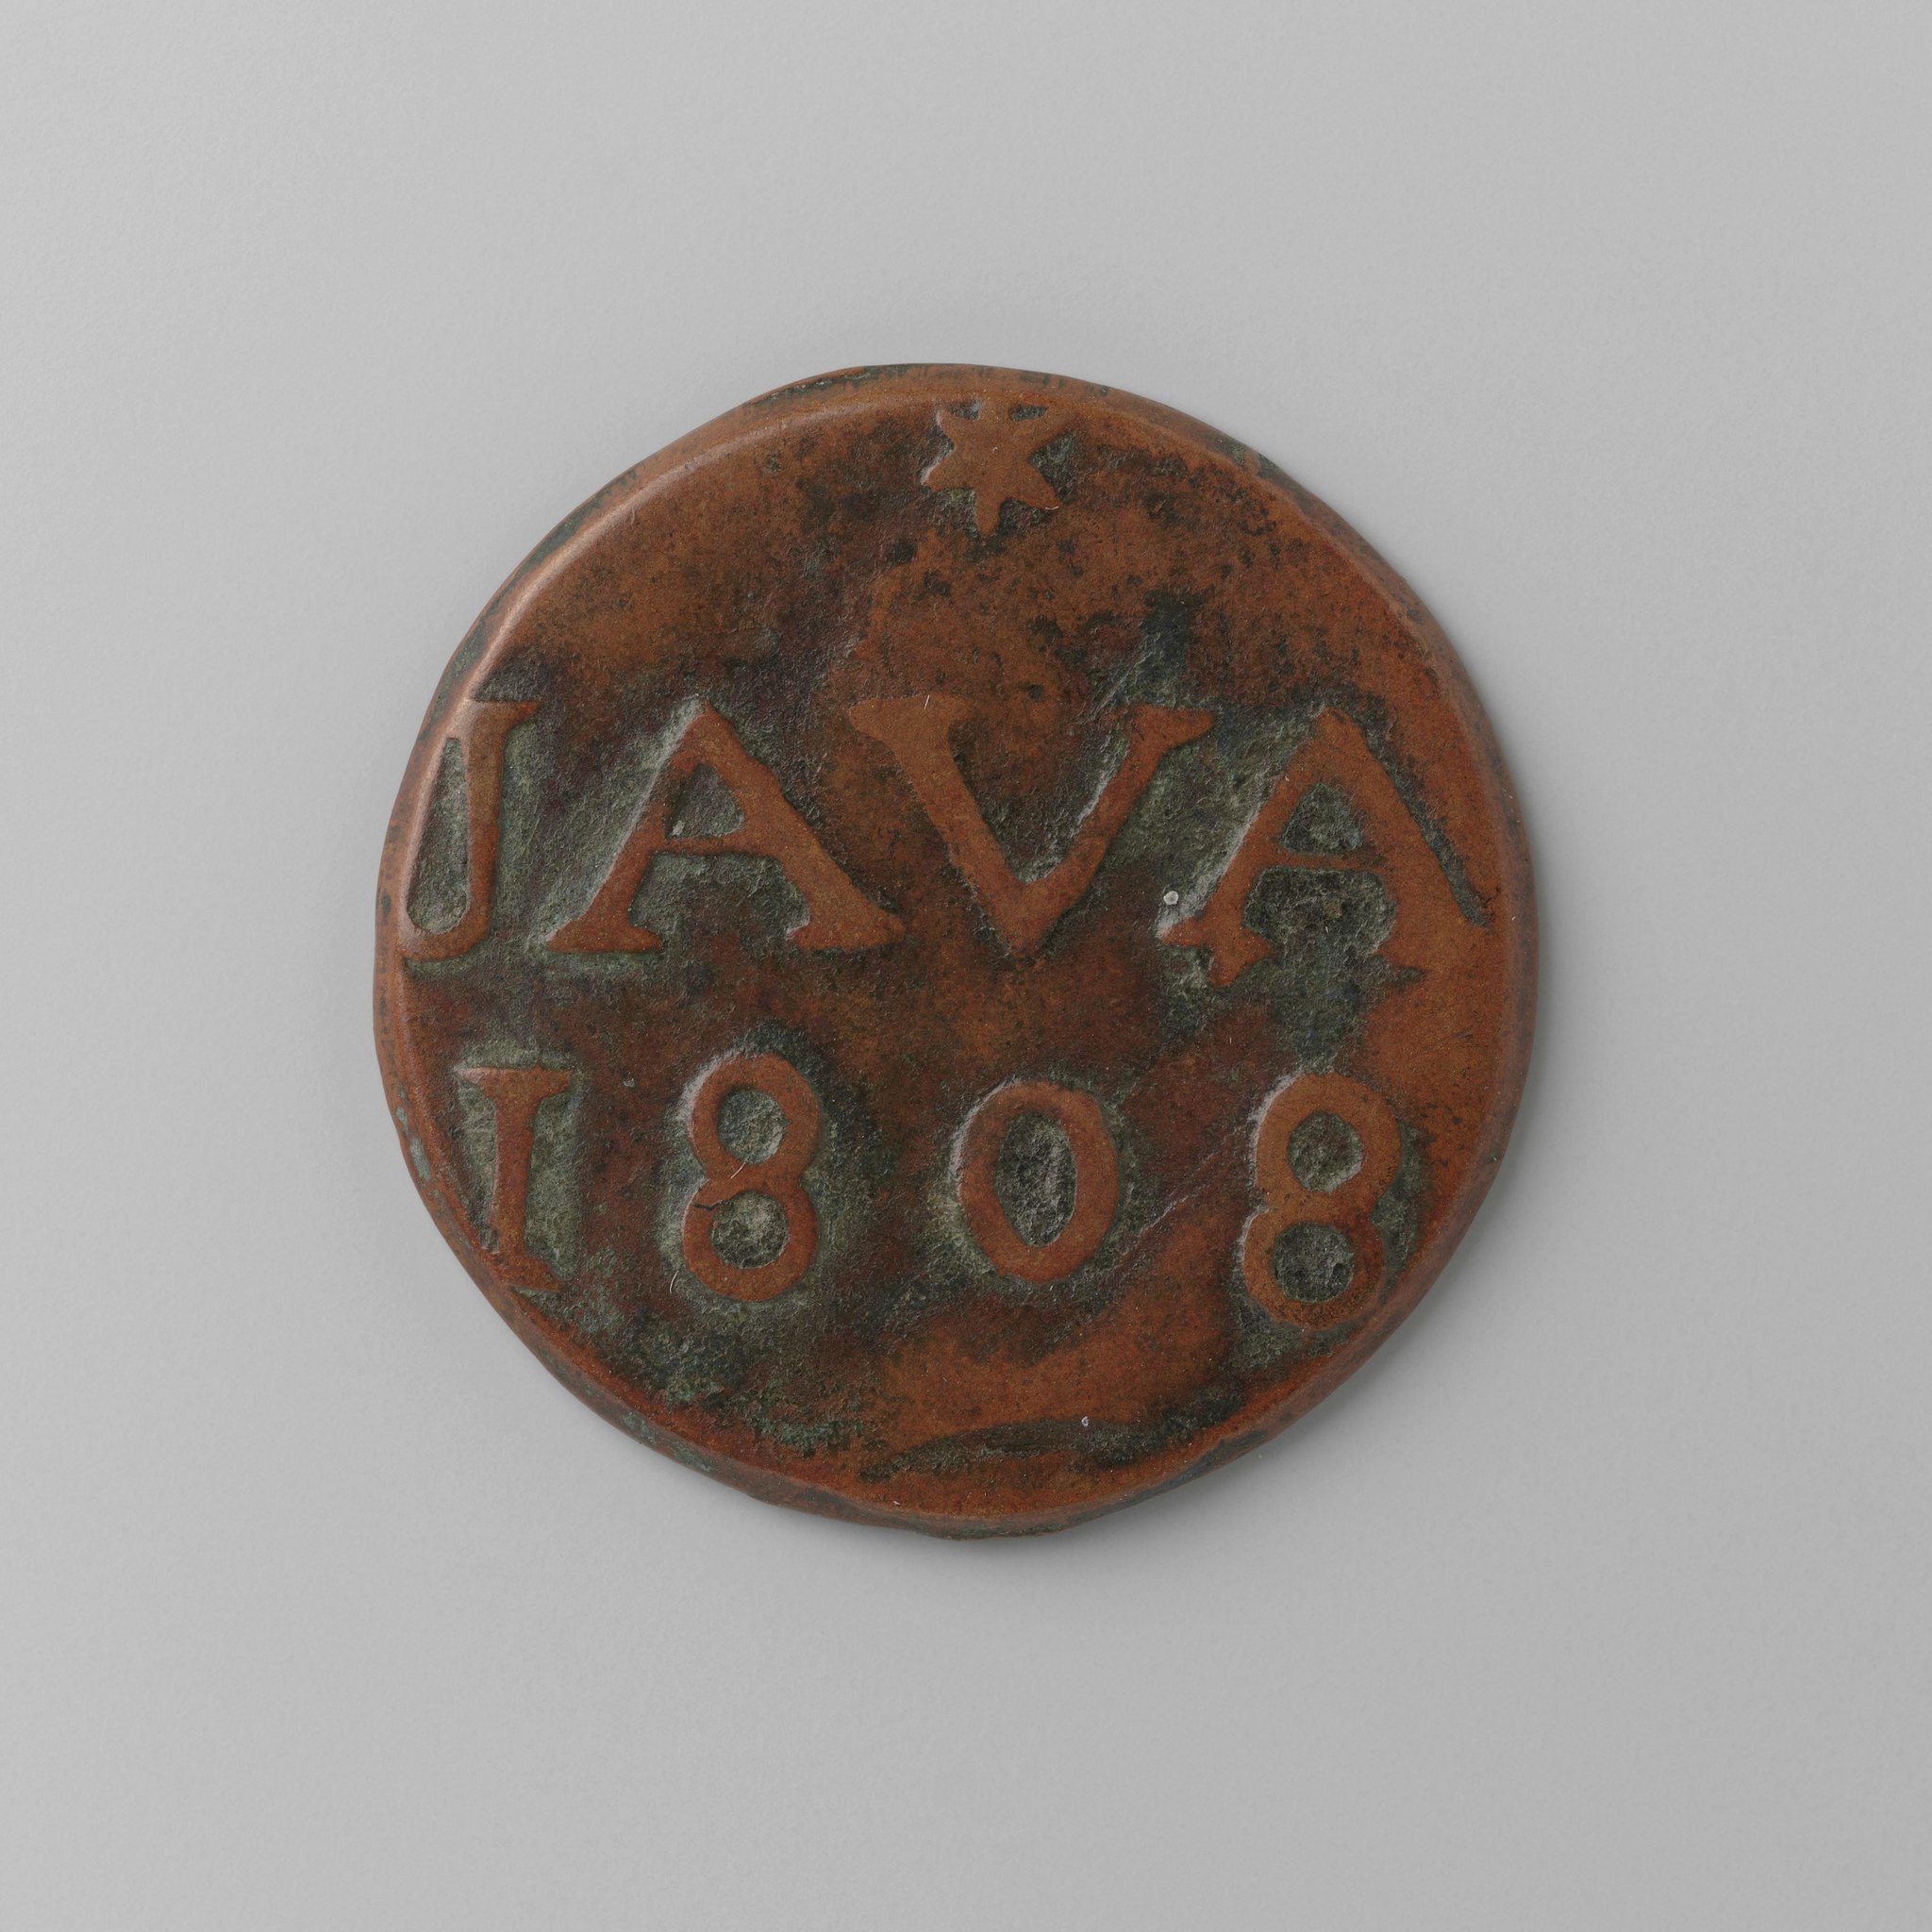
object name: coin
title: Duit van Nederlands Indië uit Java,1808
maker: louis napoleon (king of holland)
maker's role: koning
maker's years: 1778-1846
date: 1808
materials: copper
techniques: striking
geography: surabaya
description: Koperen munt. Voorzijde: opschrift, JAVA, waarboven munteken en waaronder jaartal. Keerzijde: monogram van de VOC. Daarboven muntteken. Gladde rand.